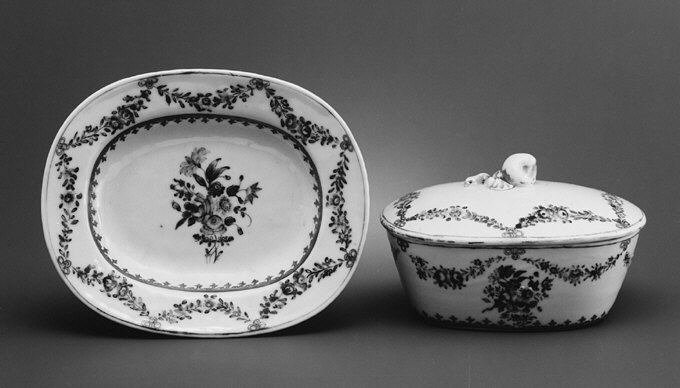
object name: butter dish with cover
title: Butter dish with cover and tray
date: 1765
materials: hard paste porcelain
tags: flowers